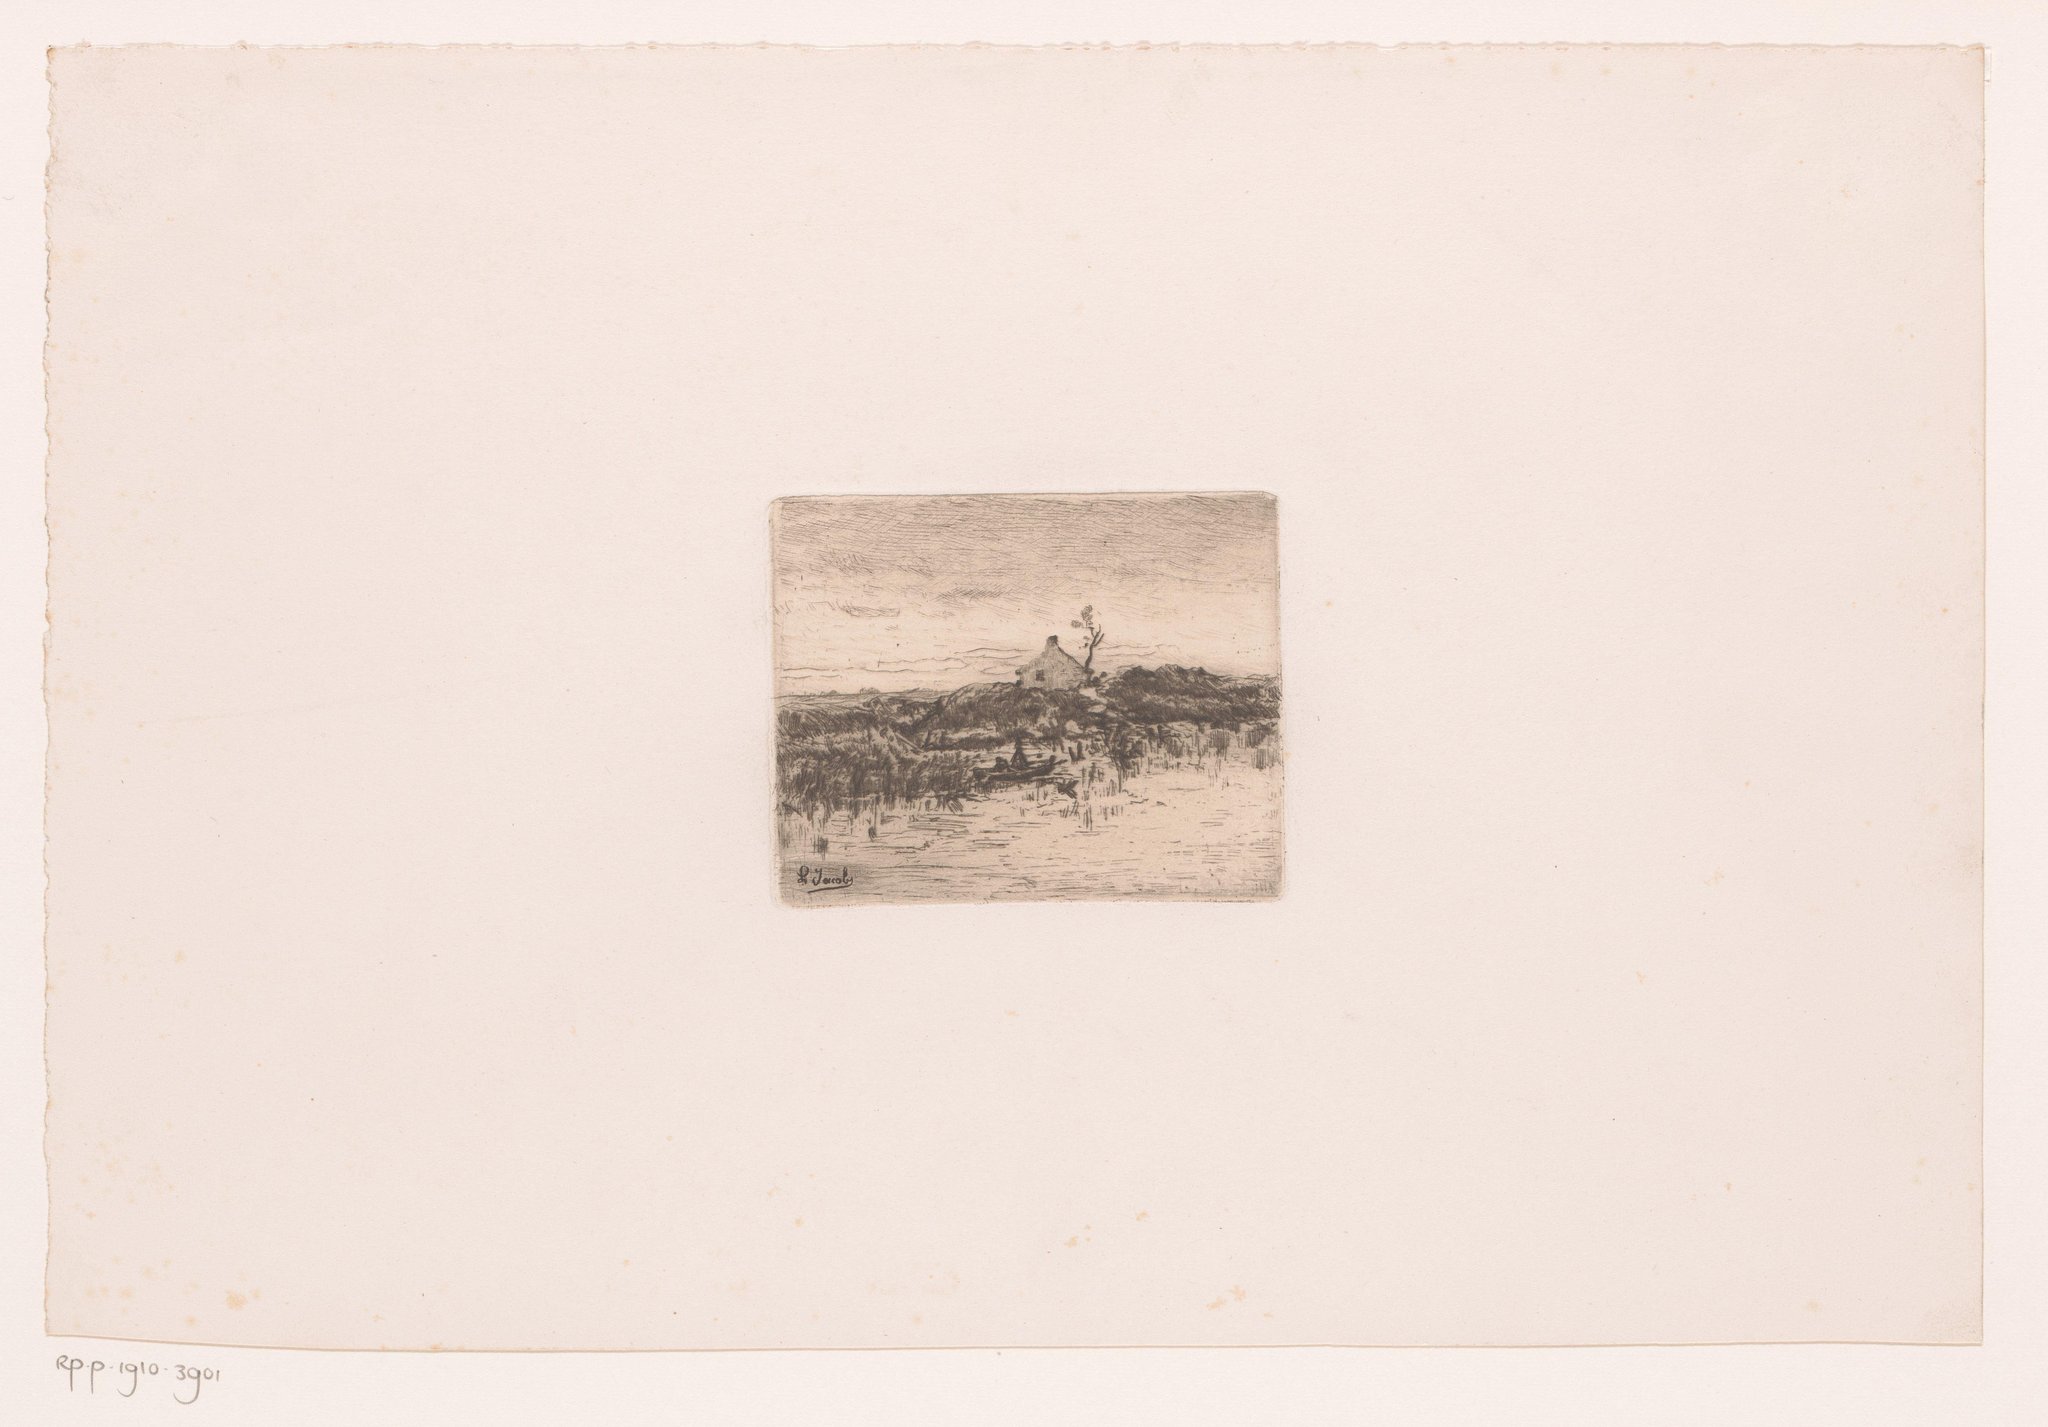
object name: print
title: Roeiboot op het water voor een boerderij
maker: louis adolphe jacobs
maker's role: painter, print maker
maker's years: 1855-1929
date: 1865-1910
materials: paper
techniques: etching, intaglio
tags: rowing-boat, canoe, etc., farm or solitary house in landscape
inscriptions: collector's mark: Lugt 2228